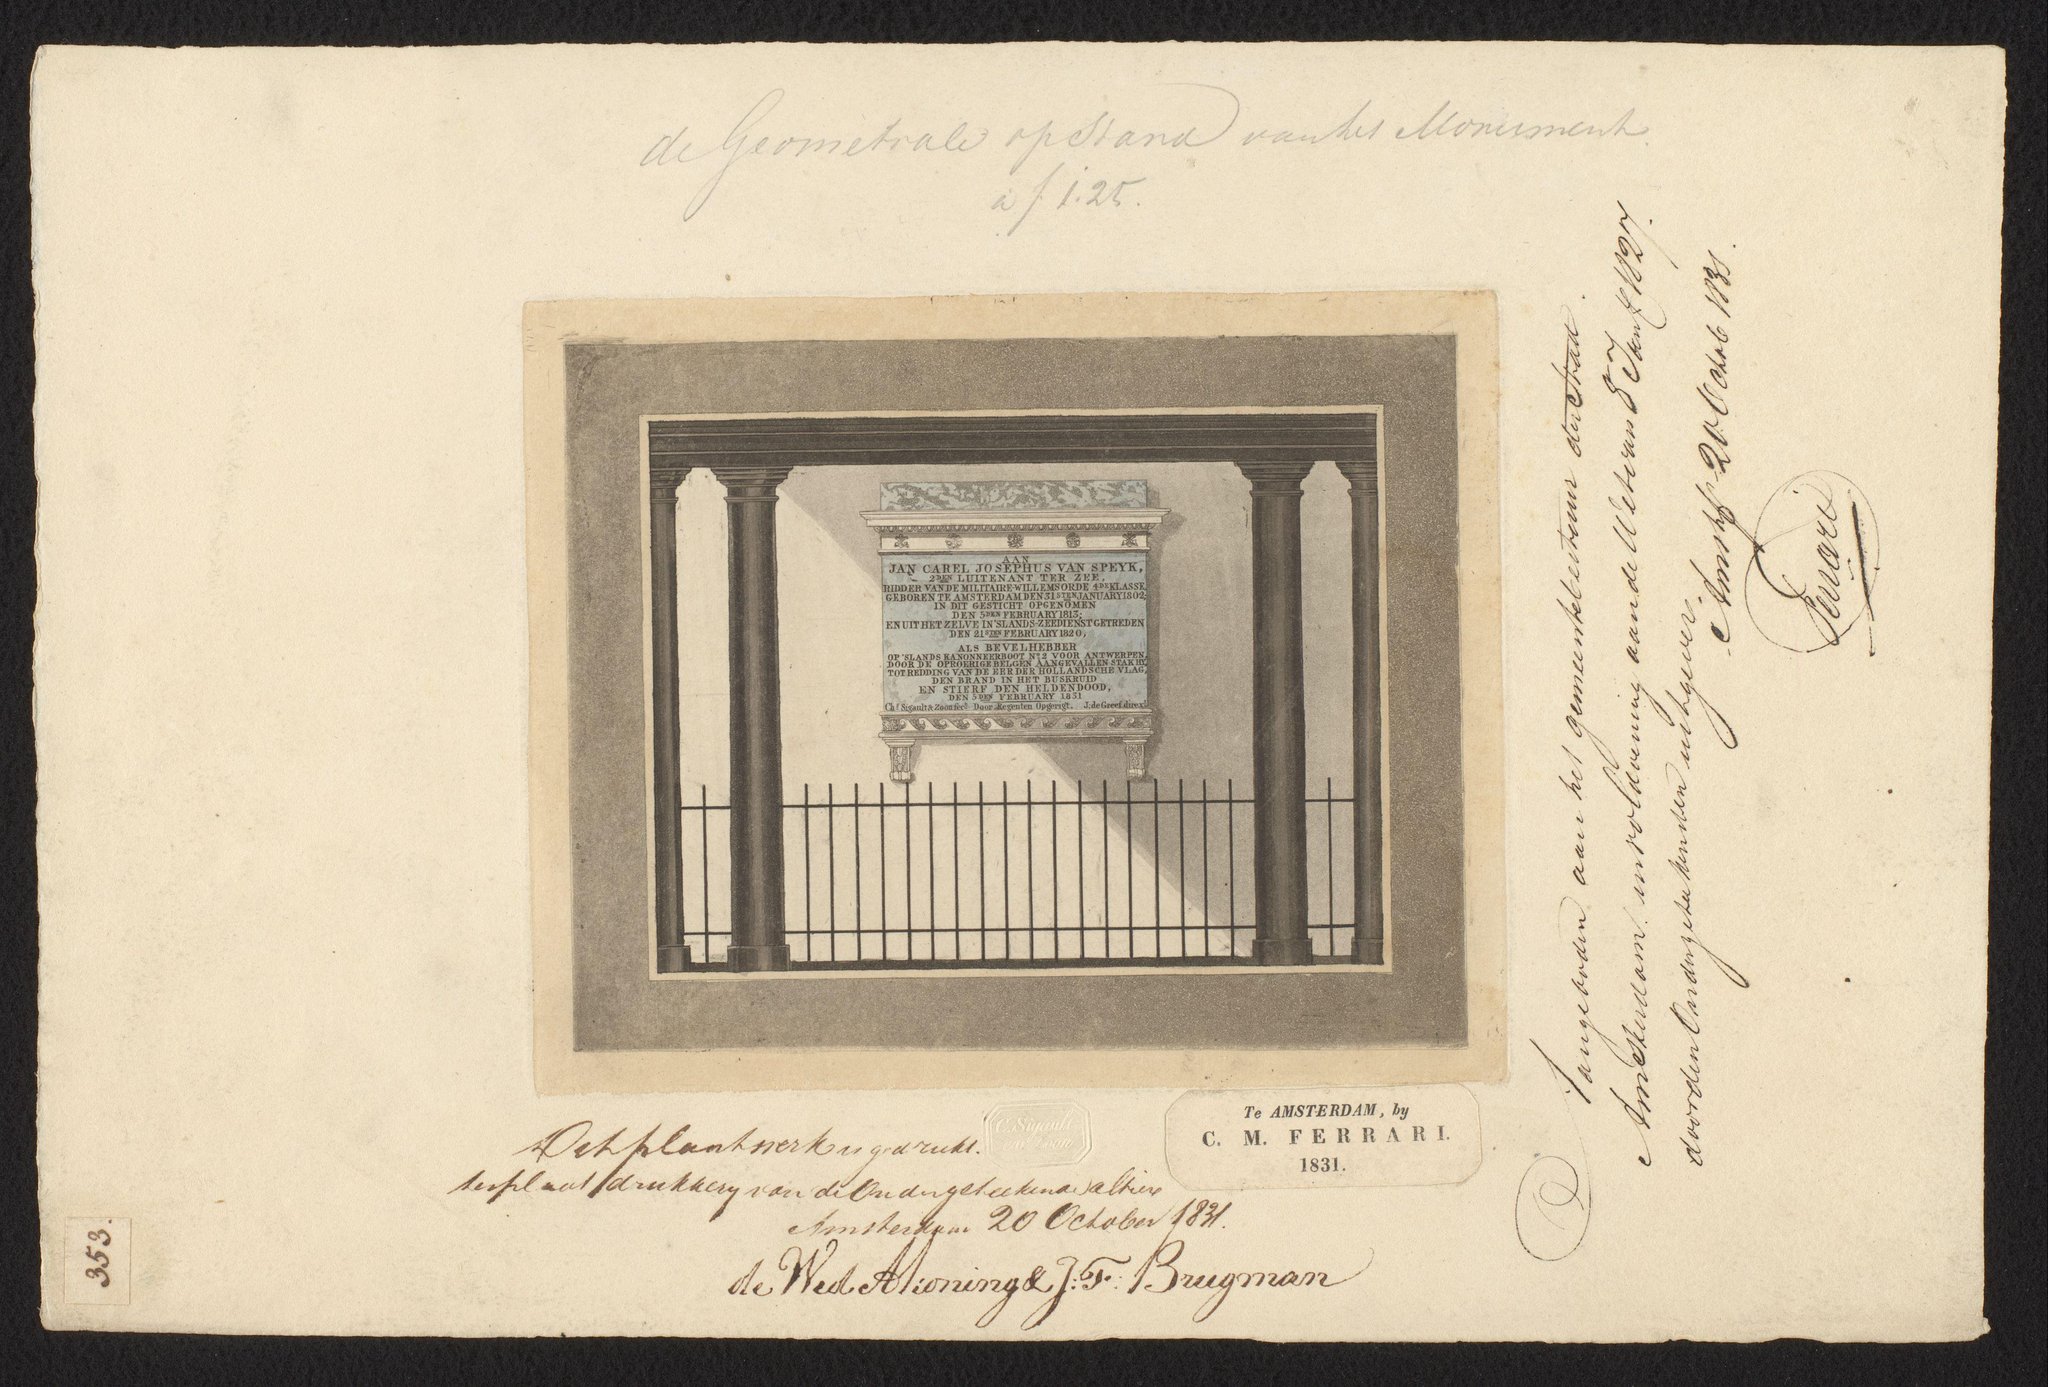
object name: print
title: Monument ter ere van Jan van Speyk in het Burgerweeshuis Amsterdam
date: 1831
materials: paper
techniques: aquatint, etching, hand coloring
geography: amsterdam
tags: antwerp, jan van speyk, other memorial structures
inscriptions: workshop stamp: ‘C. Sigault en Zoon’, inscription: ‘De Geometrale opstand van het monument à f. 1.25’, inscription: ‘Aangeboden aan het gemeentebestuur der stad Amsterdam in voldoening aan de wet van 8 Jan 1827 door den ondergetekenden uitgever. Amsterdam 20 Oct. 1831. C.M. Ferrari’, inscription: ‘Dit plaatwerk is gedrukt ter plaatdrukkerij van de ondergeteekenden alhier Amsterdam 20 October 1831. de Wed. A. Koning & J.F. Brugman’, workshop stamp: ‘Te Amsterdam, by C.M. Ferrari, 1831’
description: Gedenksteen voor Jan van Speyk, op de binnenplaats van het Burgerweeshuis te Amsterdam, 20 oktober 1831. Plaquette met opschrift: 'Aan Jan Carel Josephus van Speyk, [...] op 's lands kanonneerboot no.2 voor Antwerpen, door de oproerige Belgen aangevallen stak hy, tot redding van de eer der Hollandsche vlag, den brand in het buskruid en stierf den heldendood, den 5den February 1831'.